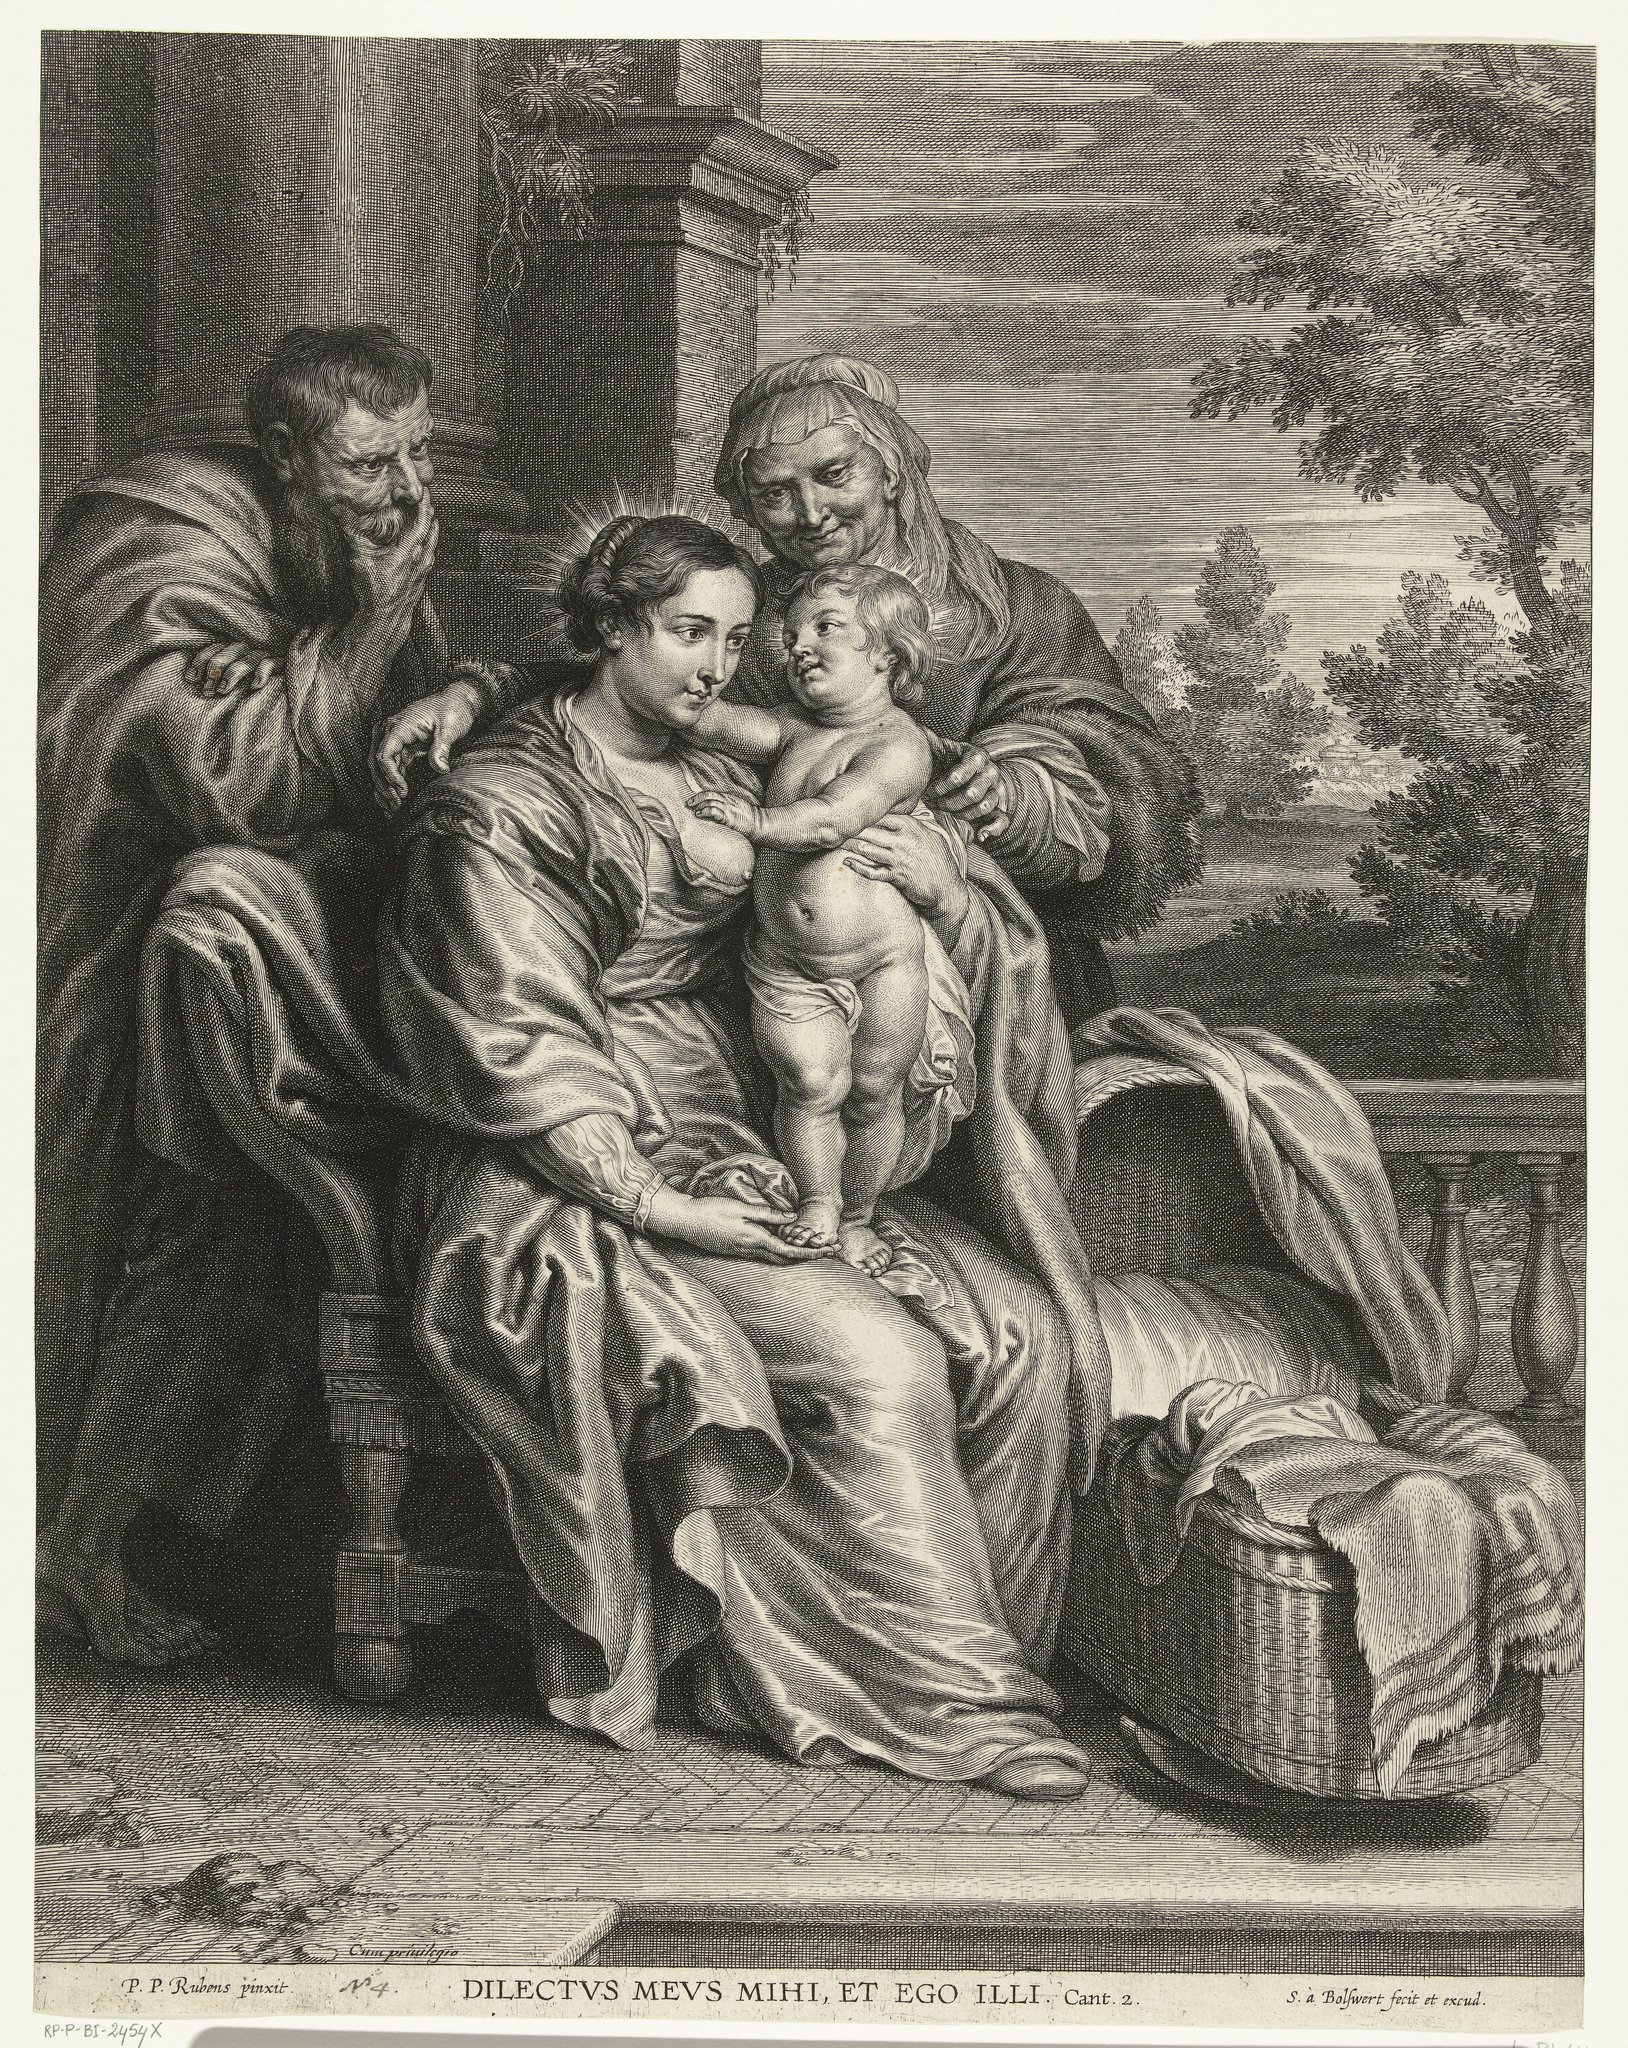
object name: print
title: Heilige familie met Anna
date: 1596-1659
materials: paper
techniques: engraving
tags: holy family, and derived representations, anna, mother of mary; possible attributes: book, christ-child, lily, virgin mary, cradle, crib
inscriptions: collector's mark: Lugt 240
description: Maria zit met het Christuskind staand op haar schoot en zij heeft een borst ontbloot. Naast haar staat een wieg. Jozef en Anna kijken liefdevol naar het kind. Onder de voorstelling staat een bijbeltekst uit Spreuken 2.